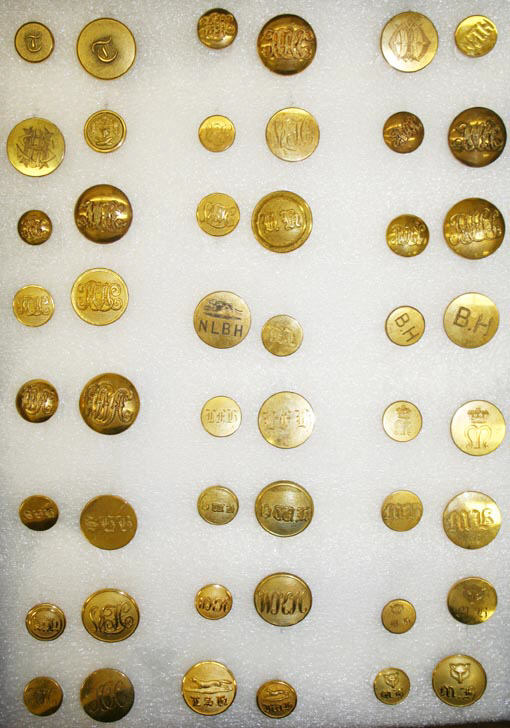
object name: button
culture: british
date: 1850-1880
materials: metal